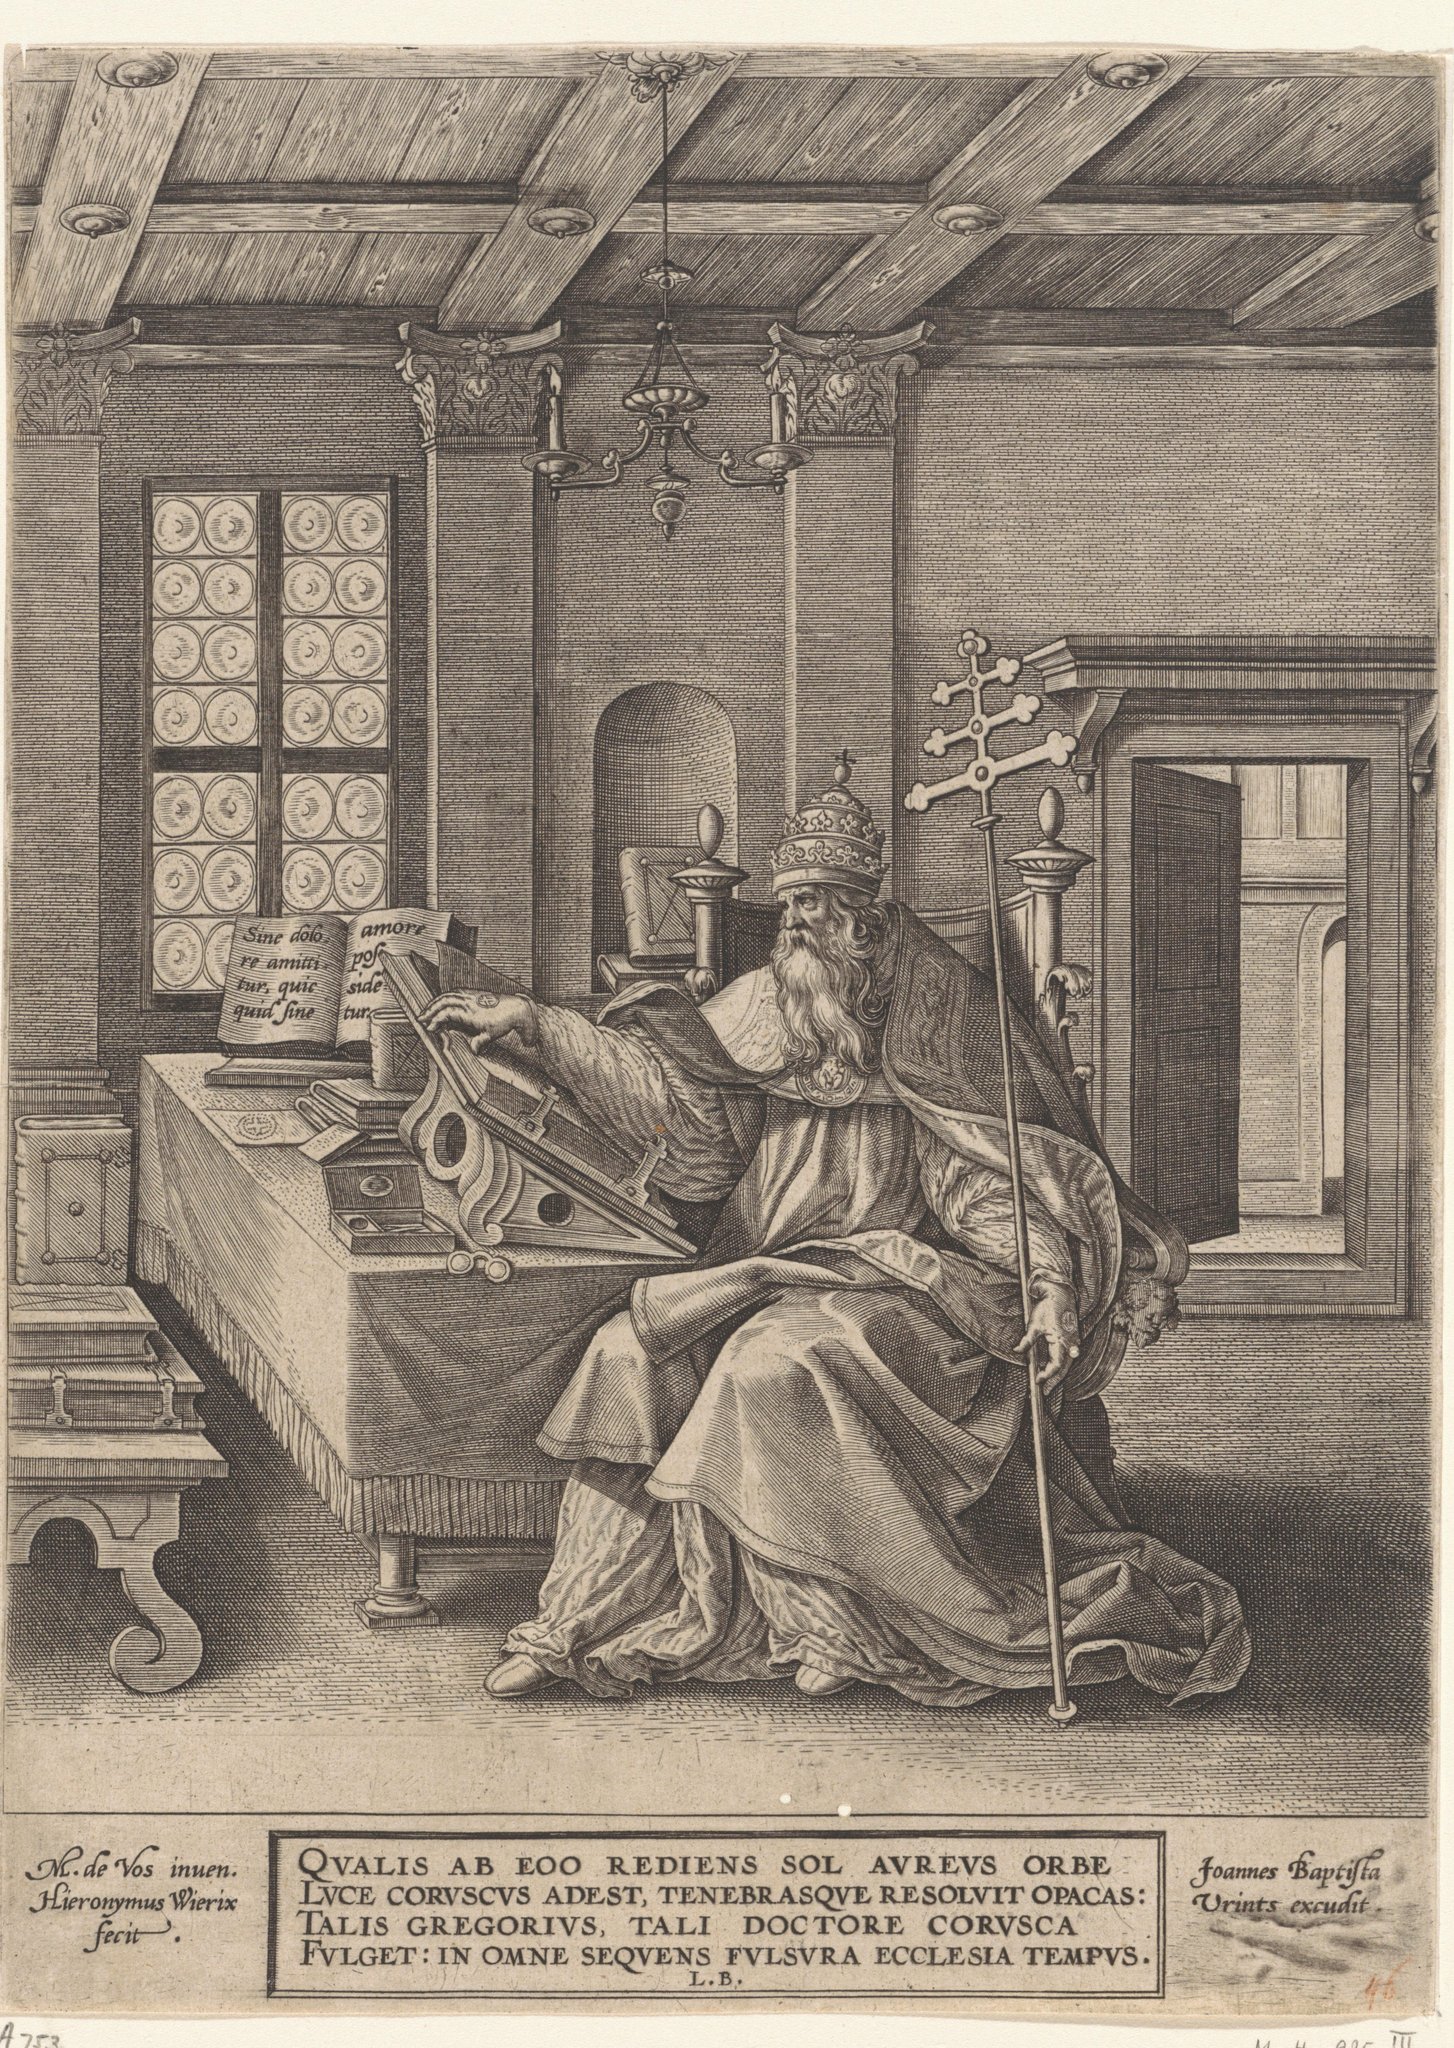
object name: print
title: Kerkvader Gregorius de Grote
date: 1586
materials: paper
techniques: engraving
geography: antwerp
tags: st. gregory the great as doctor of the latin church, with book, pen, and dove (divine inspiration)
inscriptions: collector's mark: Lugt 2228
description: De H. Gregorius de Grote zit in zijn studeervertrek aan een tafel. Hij bladert in een opengeslagen boek. Hij draagt het pauselijk gewaad en de tiara, en houdt de pontificale kruisstaf vast. In het kader in de marge een vierregelig onderschrift in het Latijn.